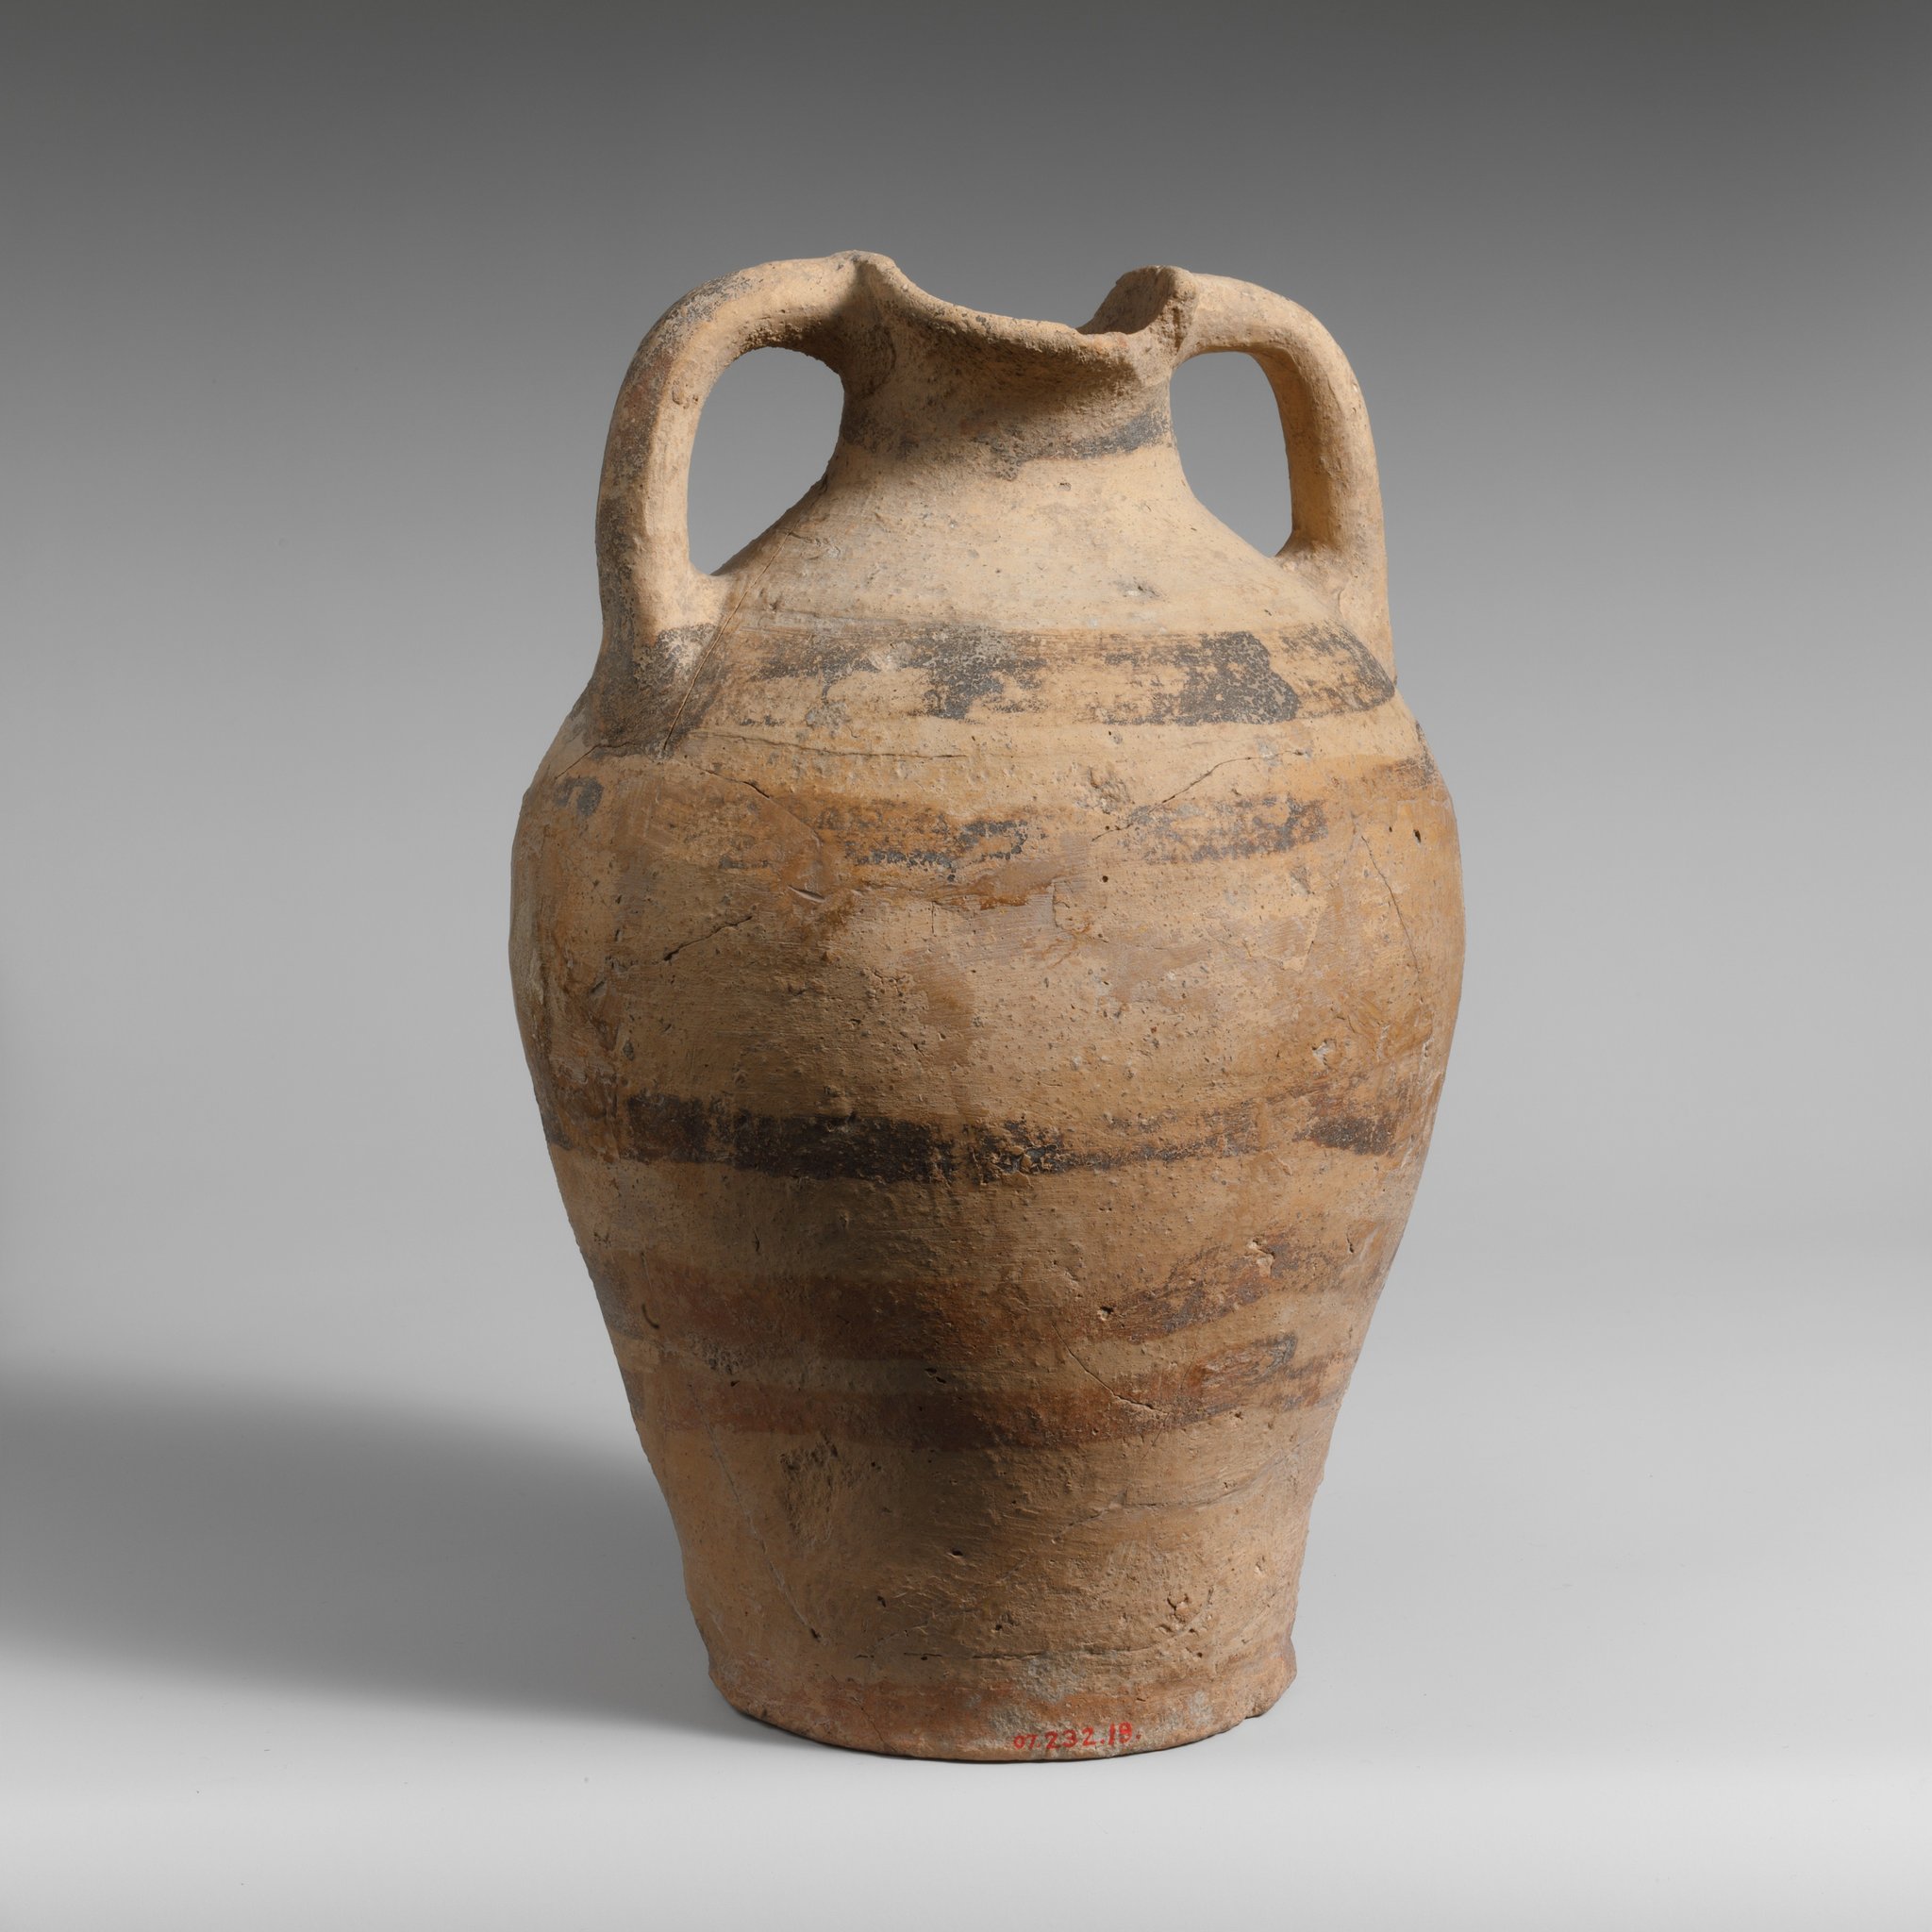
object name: amphora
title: Terracotta oval-mouthed amphora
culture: minoan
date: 1750-1600 BCE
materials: terracotta